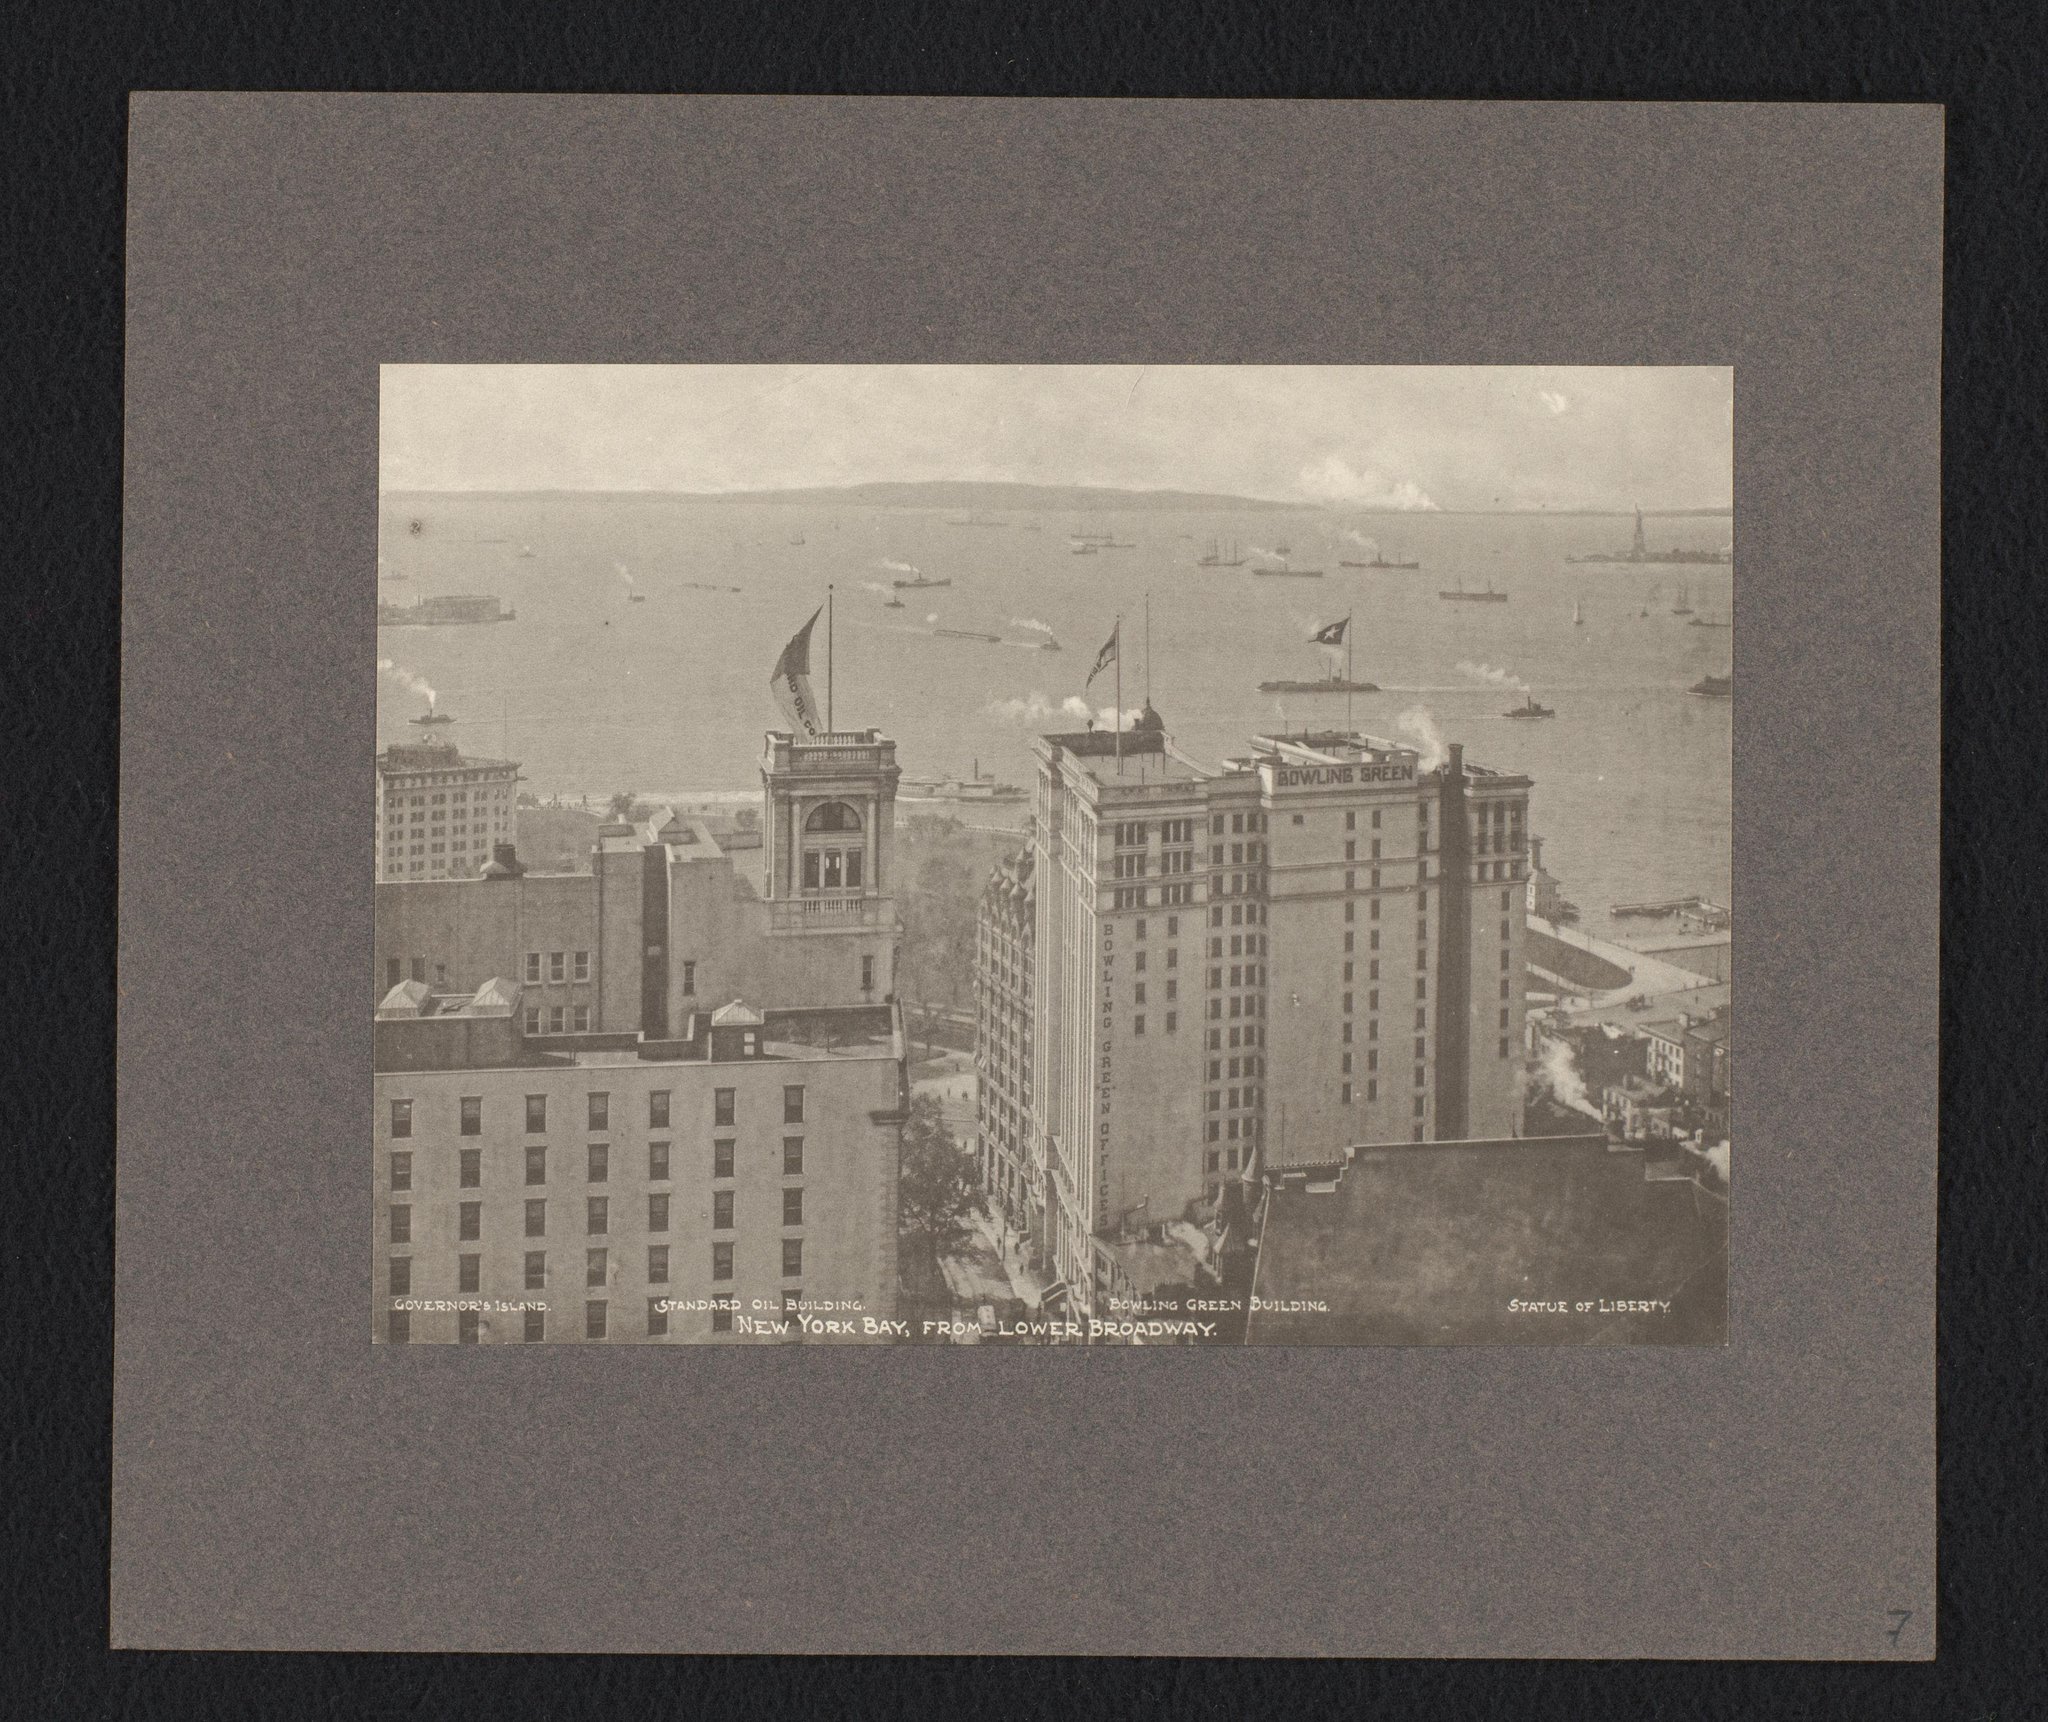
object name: album leaf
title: Governor's Island. Standard Oil Building. Bowling Green Building. Statue of Liberty. New York Bay, from Lower Broadway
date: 1902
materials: paper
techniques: photograph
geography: new york city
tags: gulf, bay, city-view in general; 'veduta', exterior ~ representation of a building, statue of liberty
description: Deze prent maakt deel uit van een album.